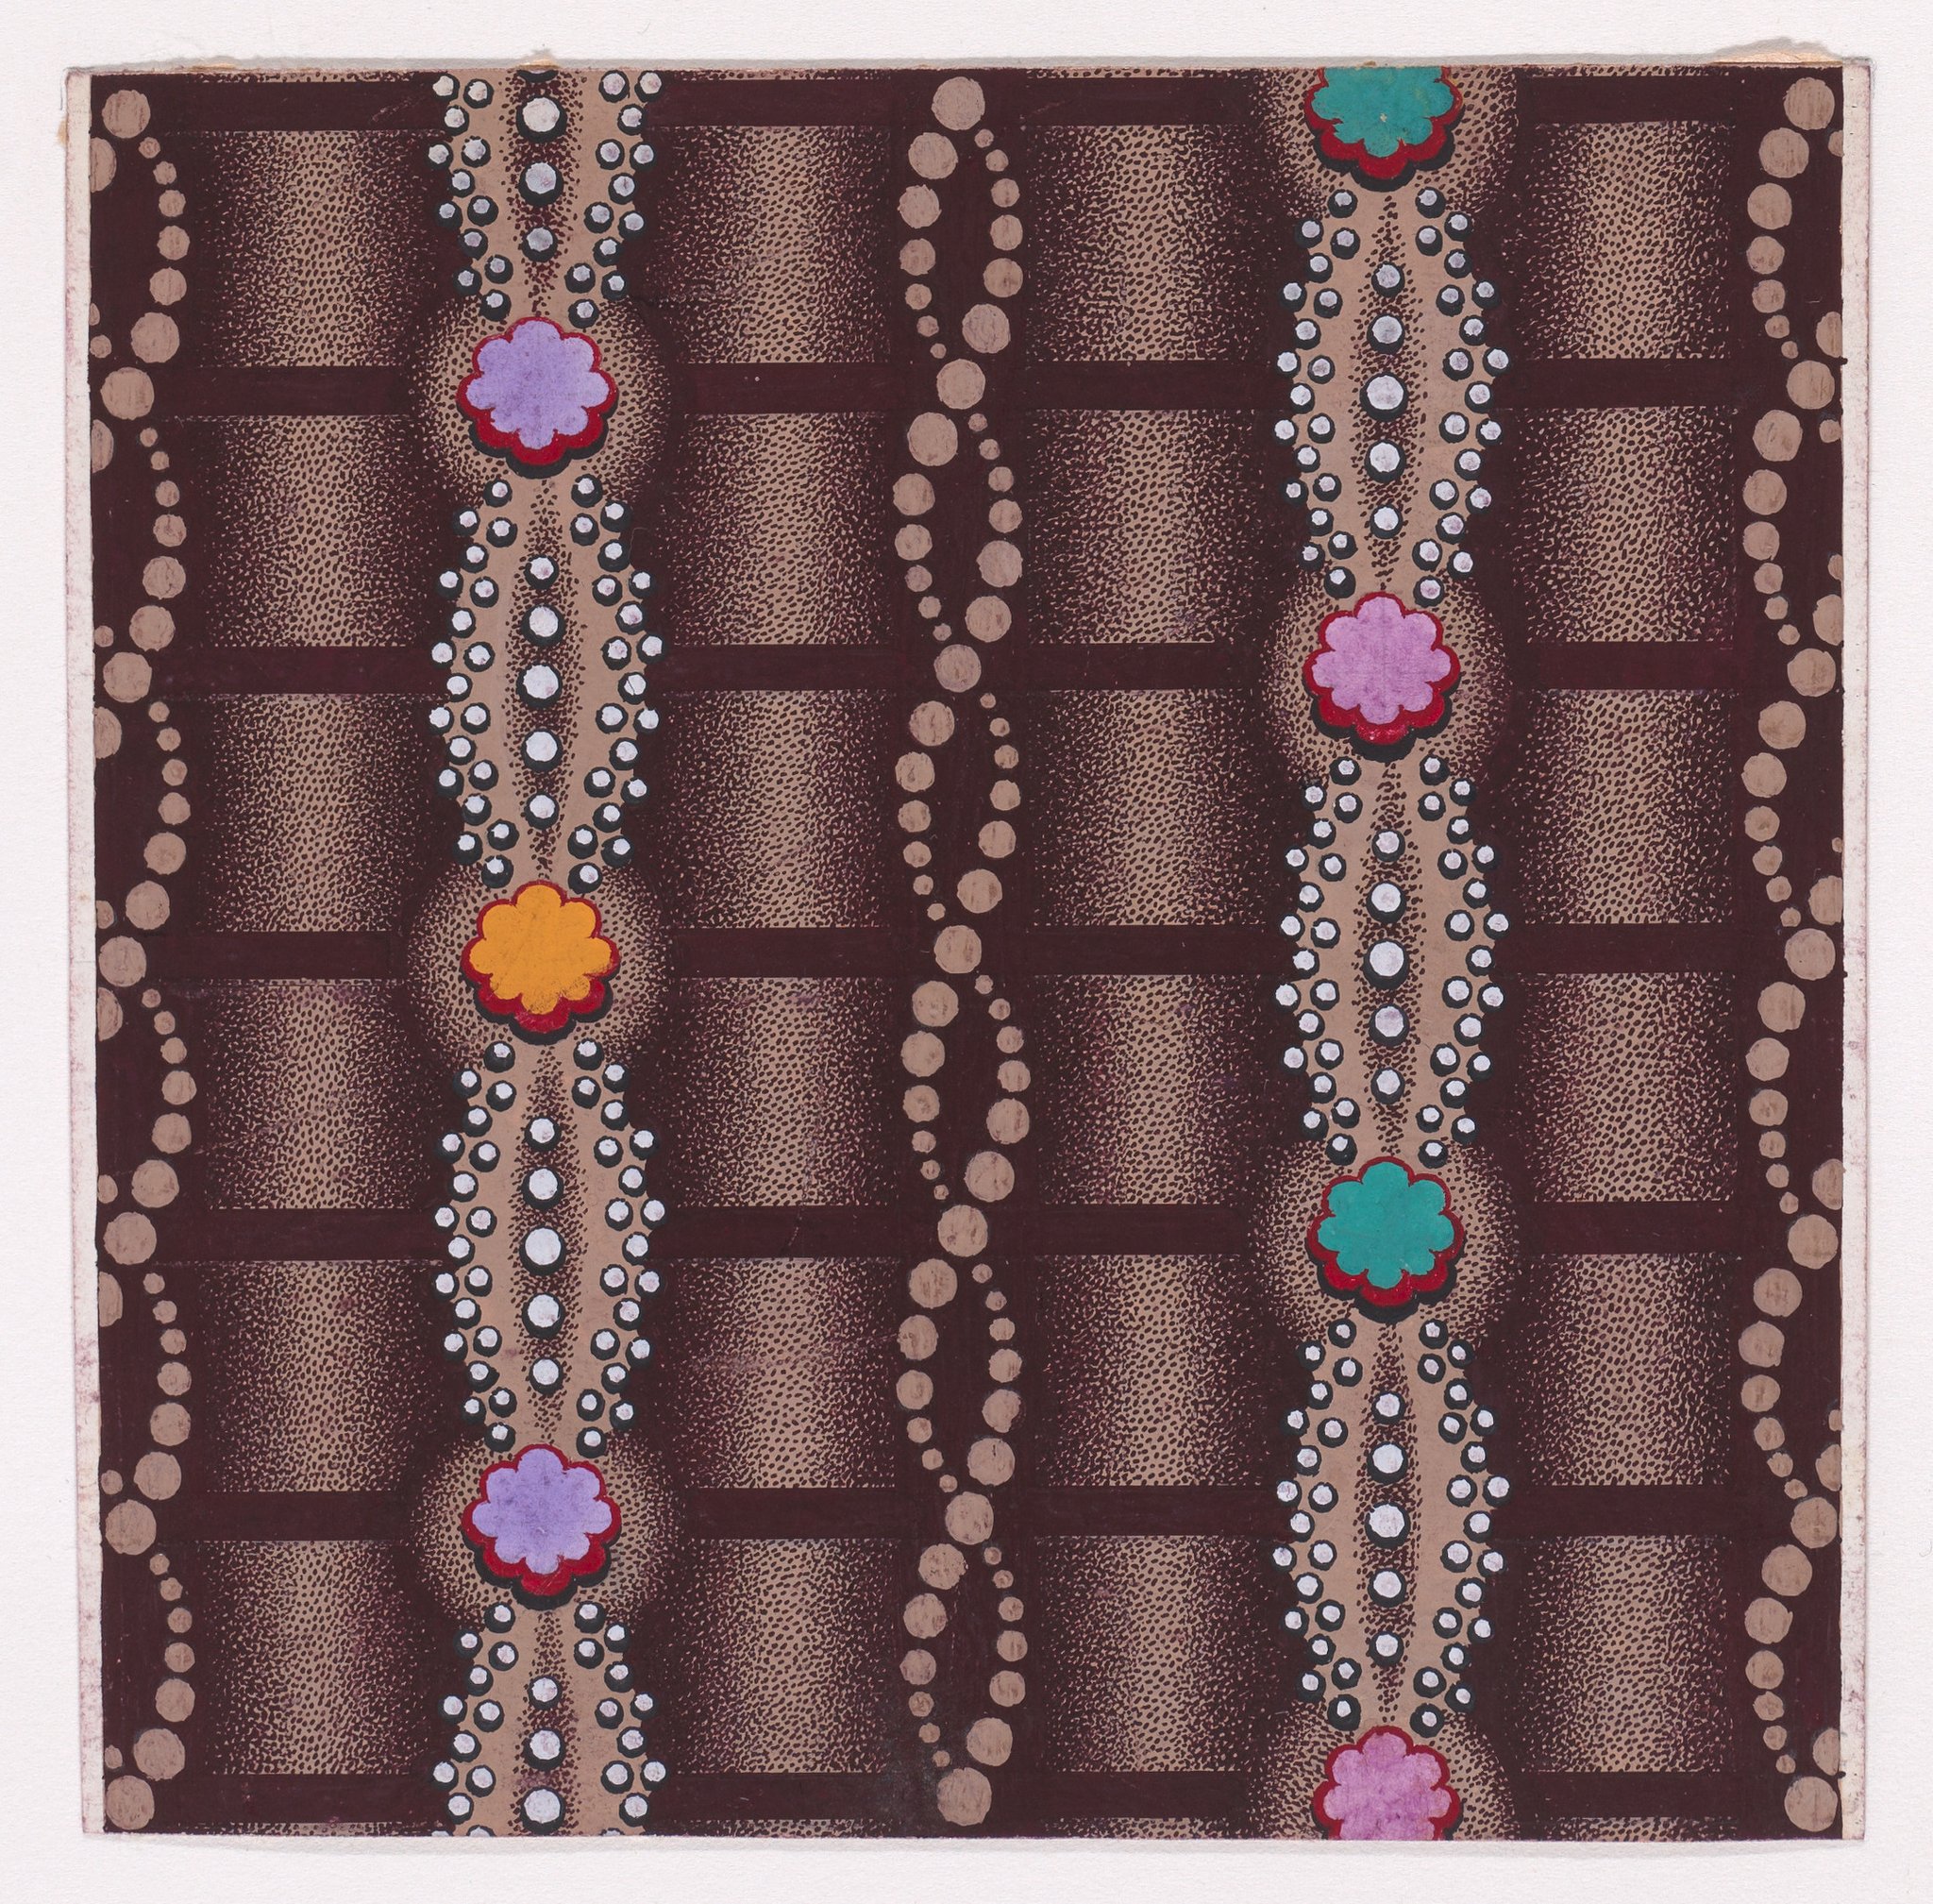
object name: drawing ornament architecture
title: Textile Design with Alternating Vertical Twisting Strips of Dots and Garlands of Pearls and Rosettes over a Striped Background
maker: anonymous, alsatian, 19th century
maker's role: artist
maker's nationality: alsatian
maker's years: 1800-1900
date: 1840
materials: gouache